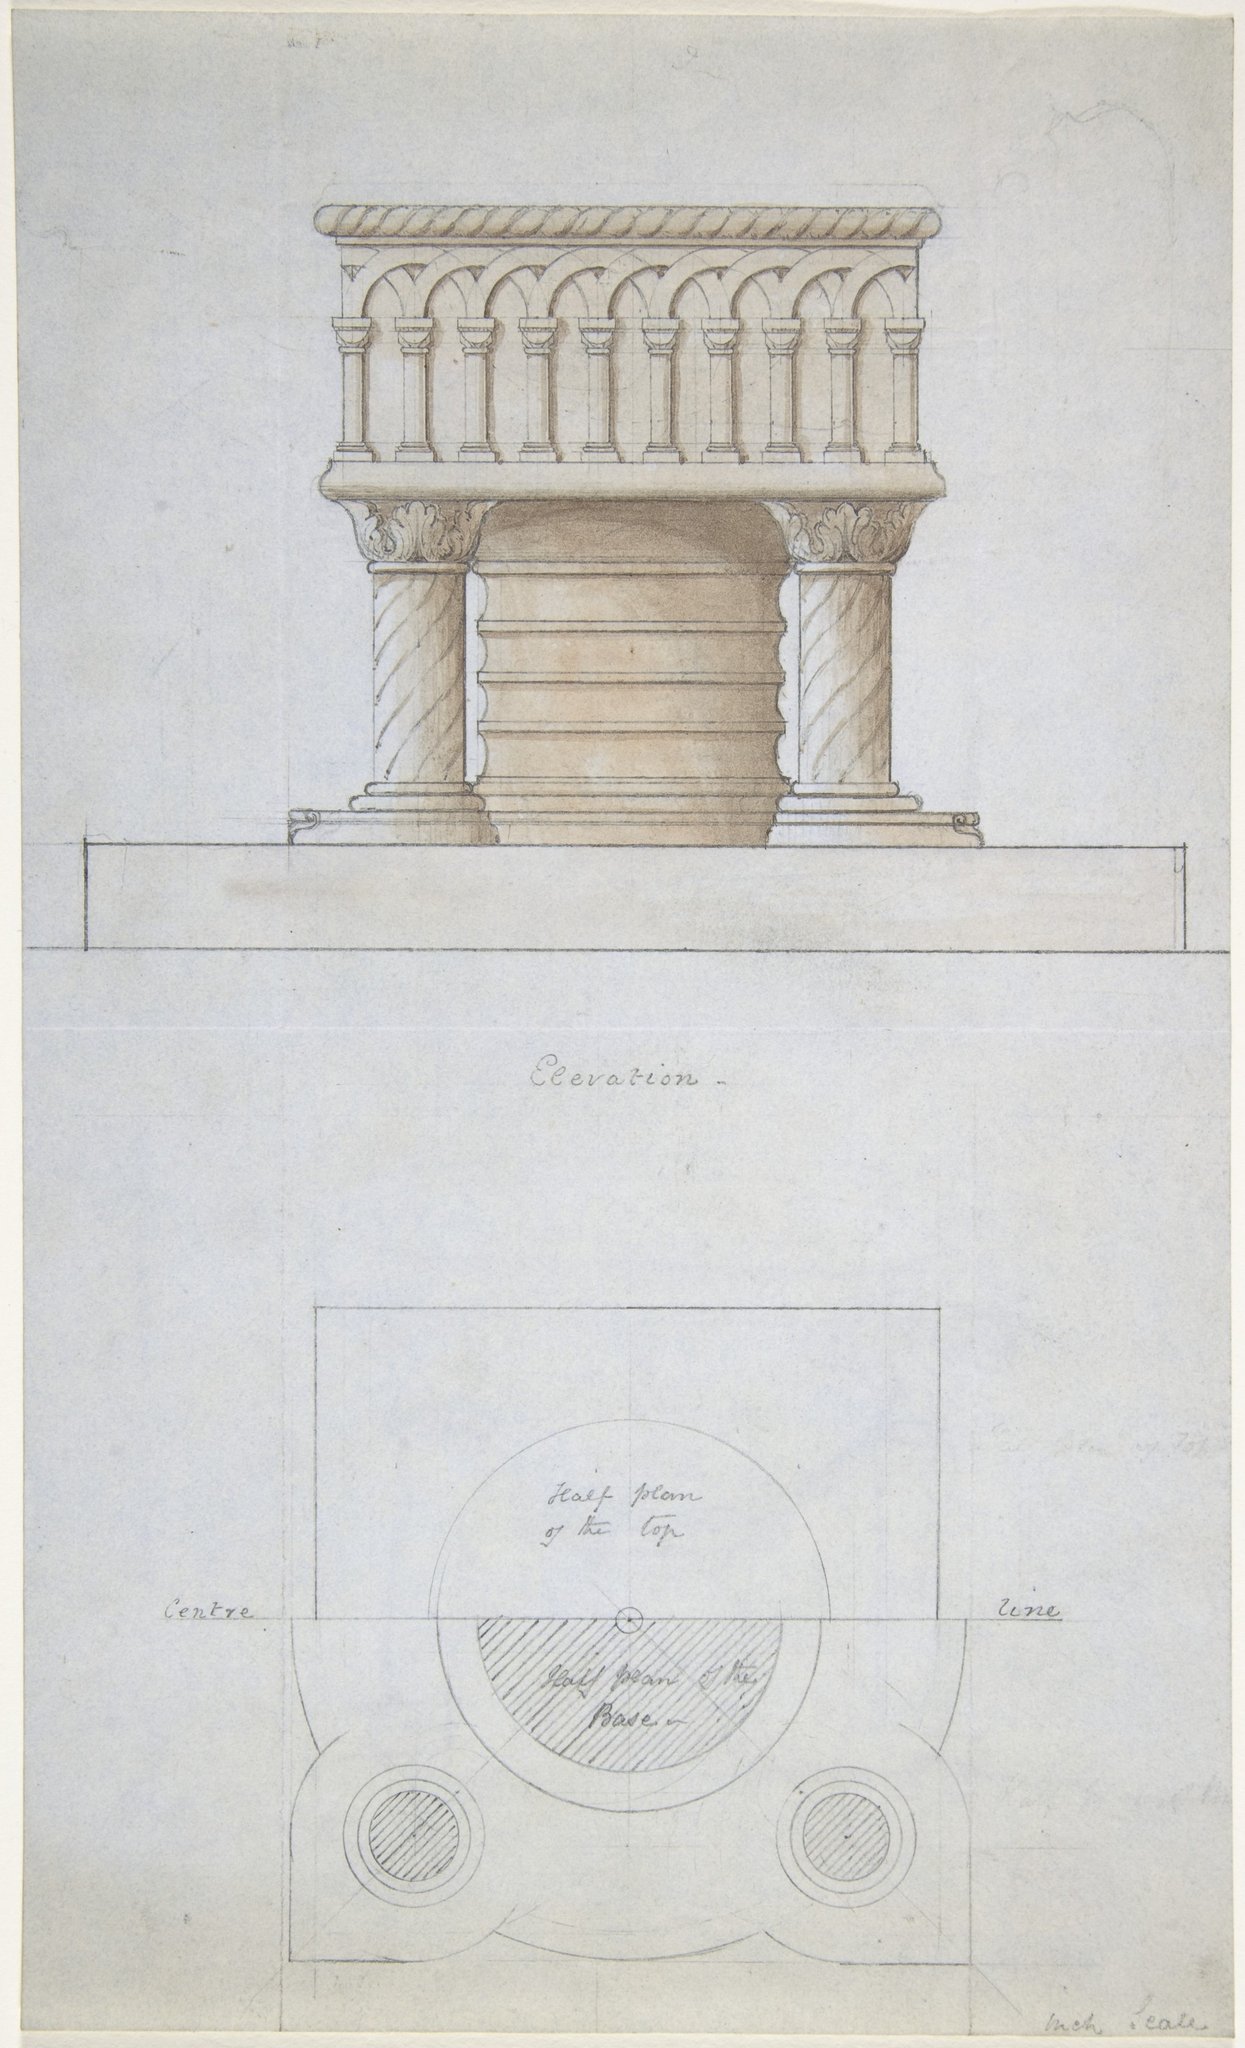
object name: drawing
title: One Font and Plan (recto); Two Romanesque Style Fonts (verso)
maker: anonymous, british, 19th century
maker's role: artist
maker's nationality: british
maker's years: 1800-1900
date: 1834-1866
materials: graphite, ink, paper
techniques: brush, pen, wash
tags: baptismal fonts